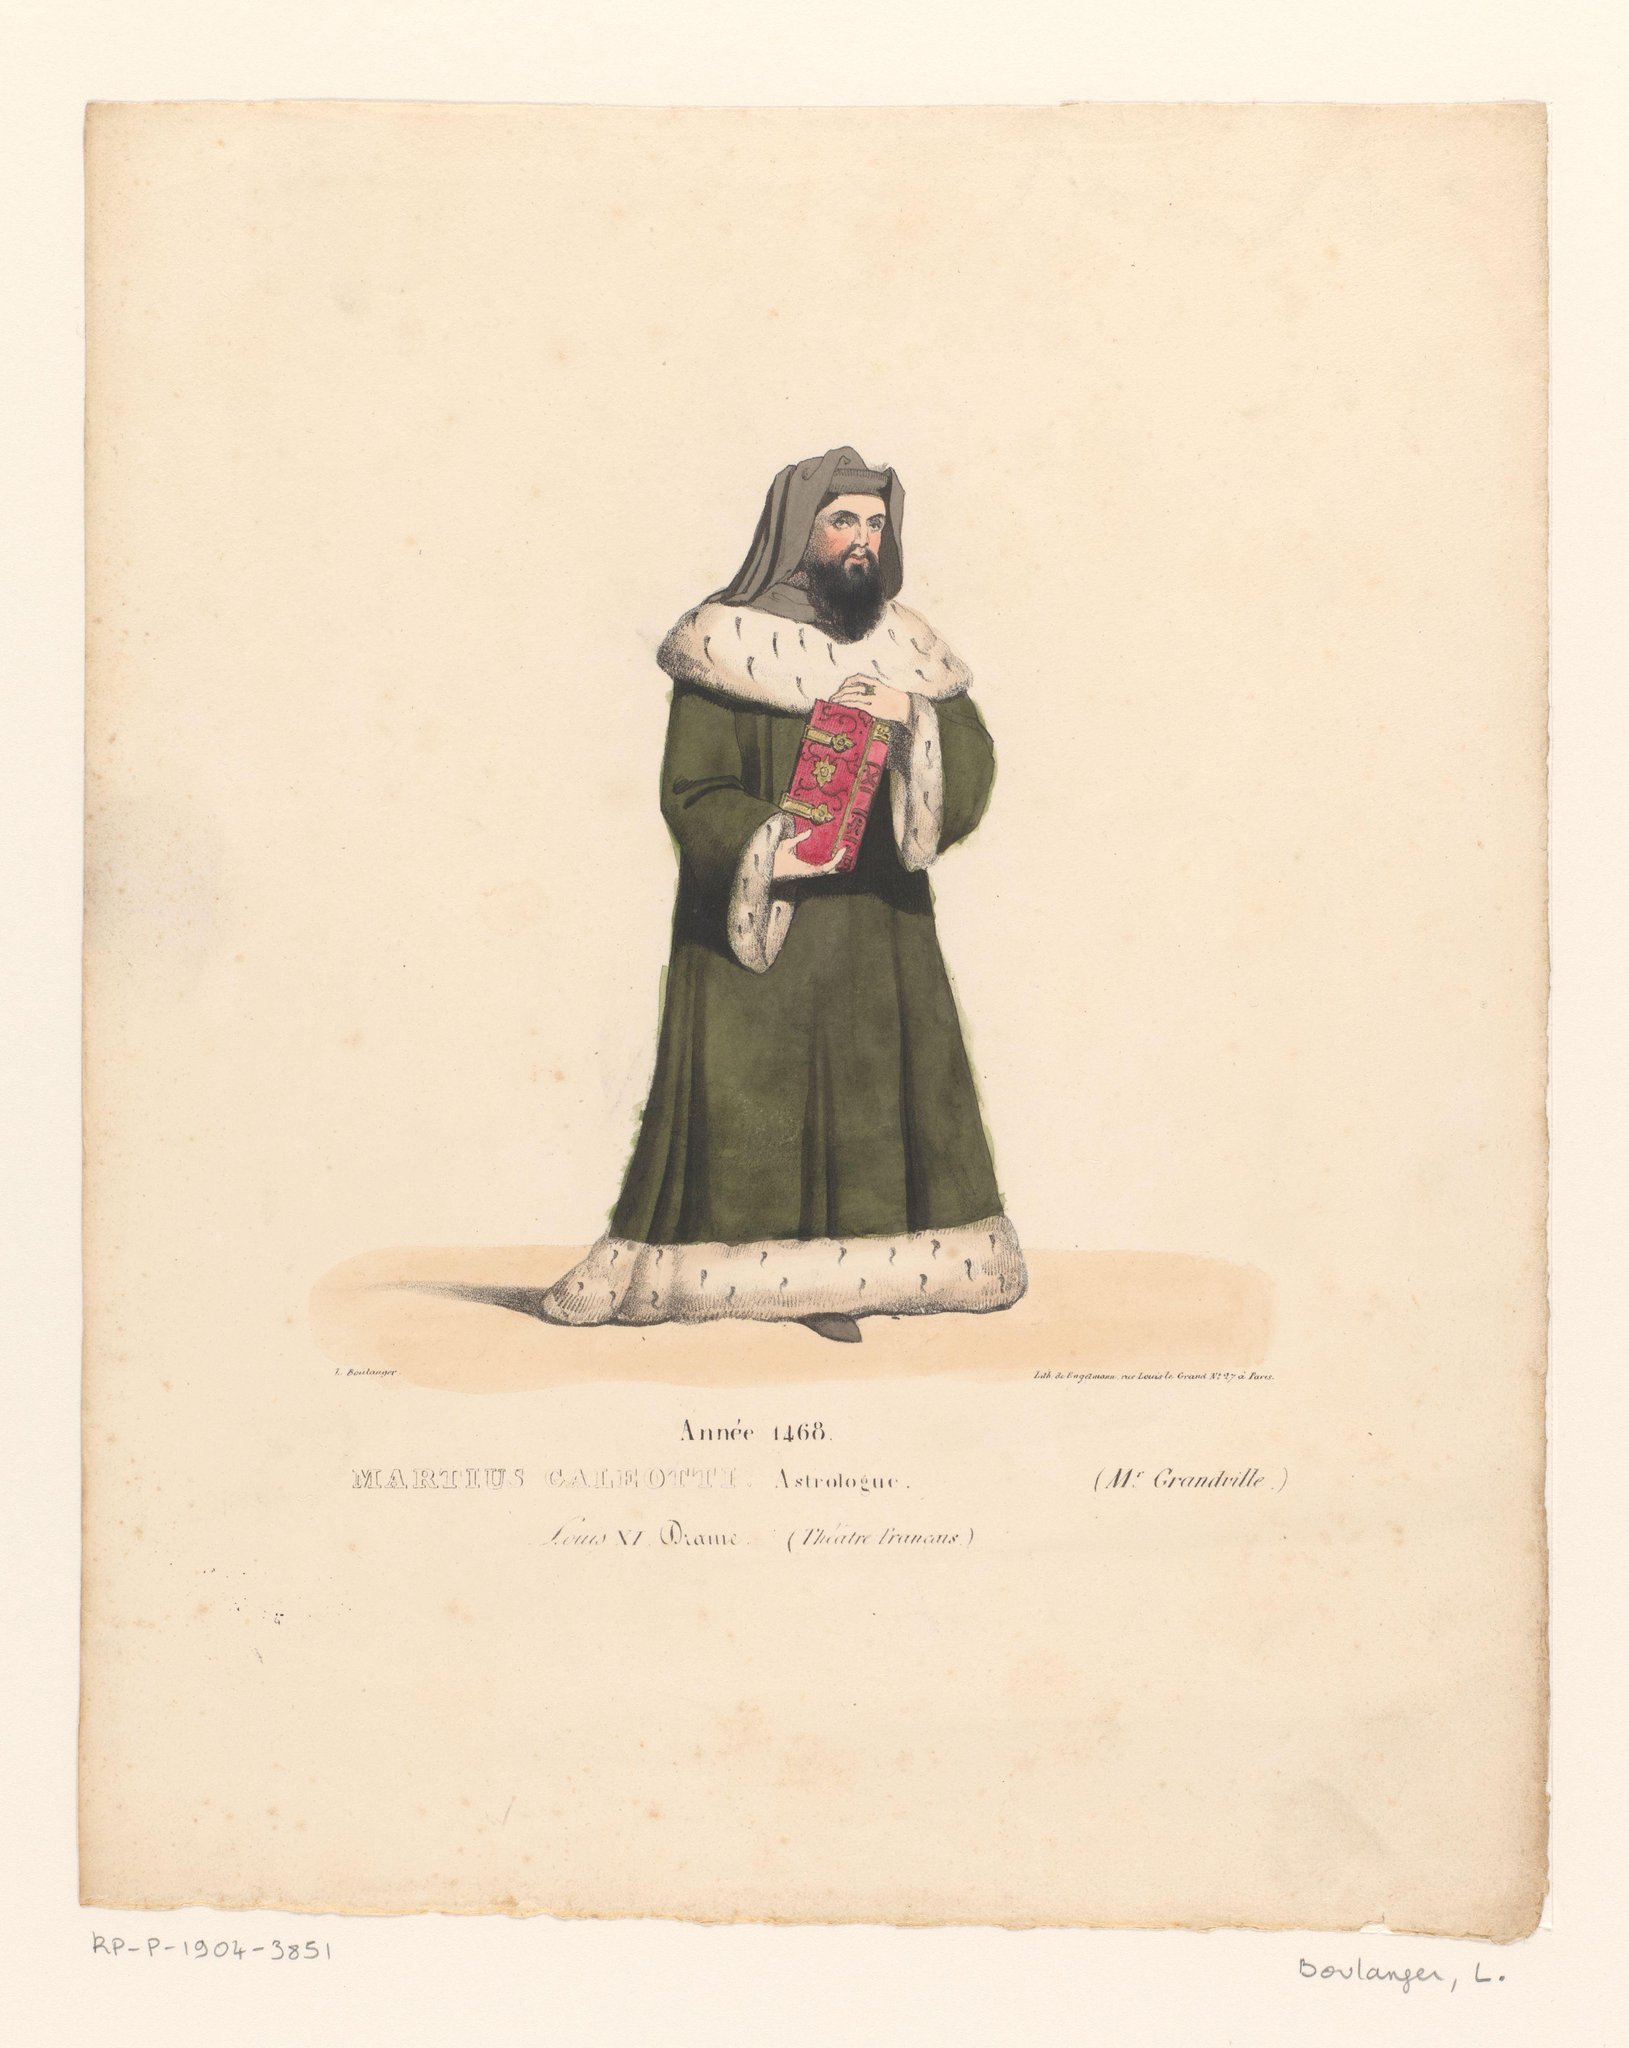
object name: print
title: Théâtre Français: recueil de costumes par MM. J. Alaux et L. Duponchel d'après les dessins manuscrits de la Bibliothèque de la Comédie-Française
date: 1826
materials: paper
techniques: hand coloring, lithograph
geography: paris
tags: stage costume, actor (on the stage), tragedy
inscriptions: collector's mark: Lugt 2228a